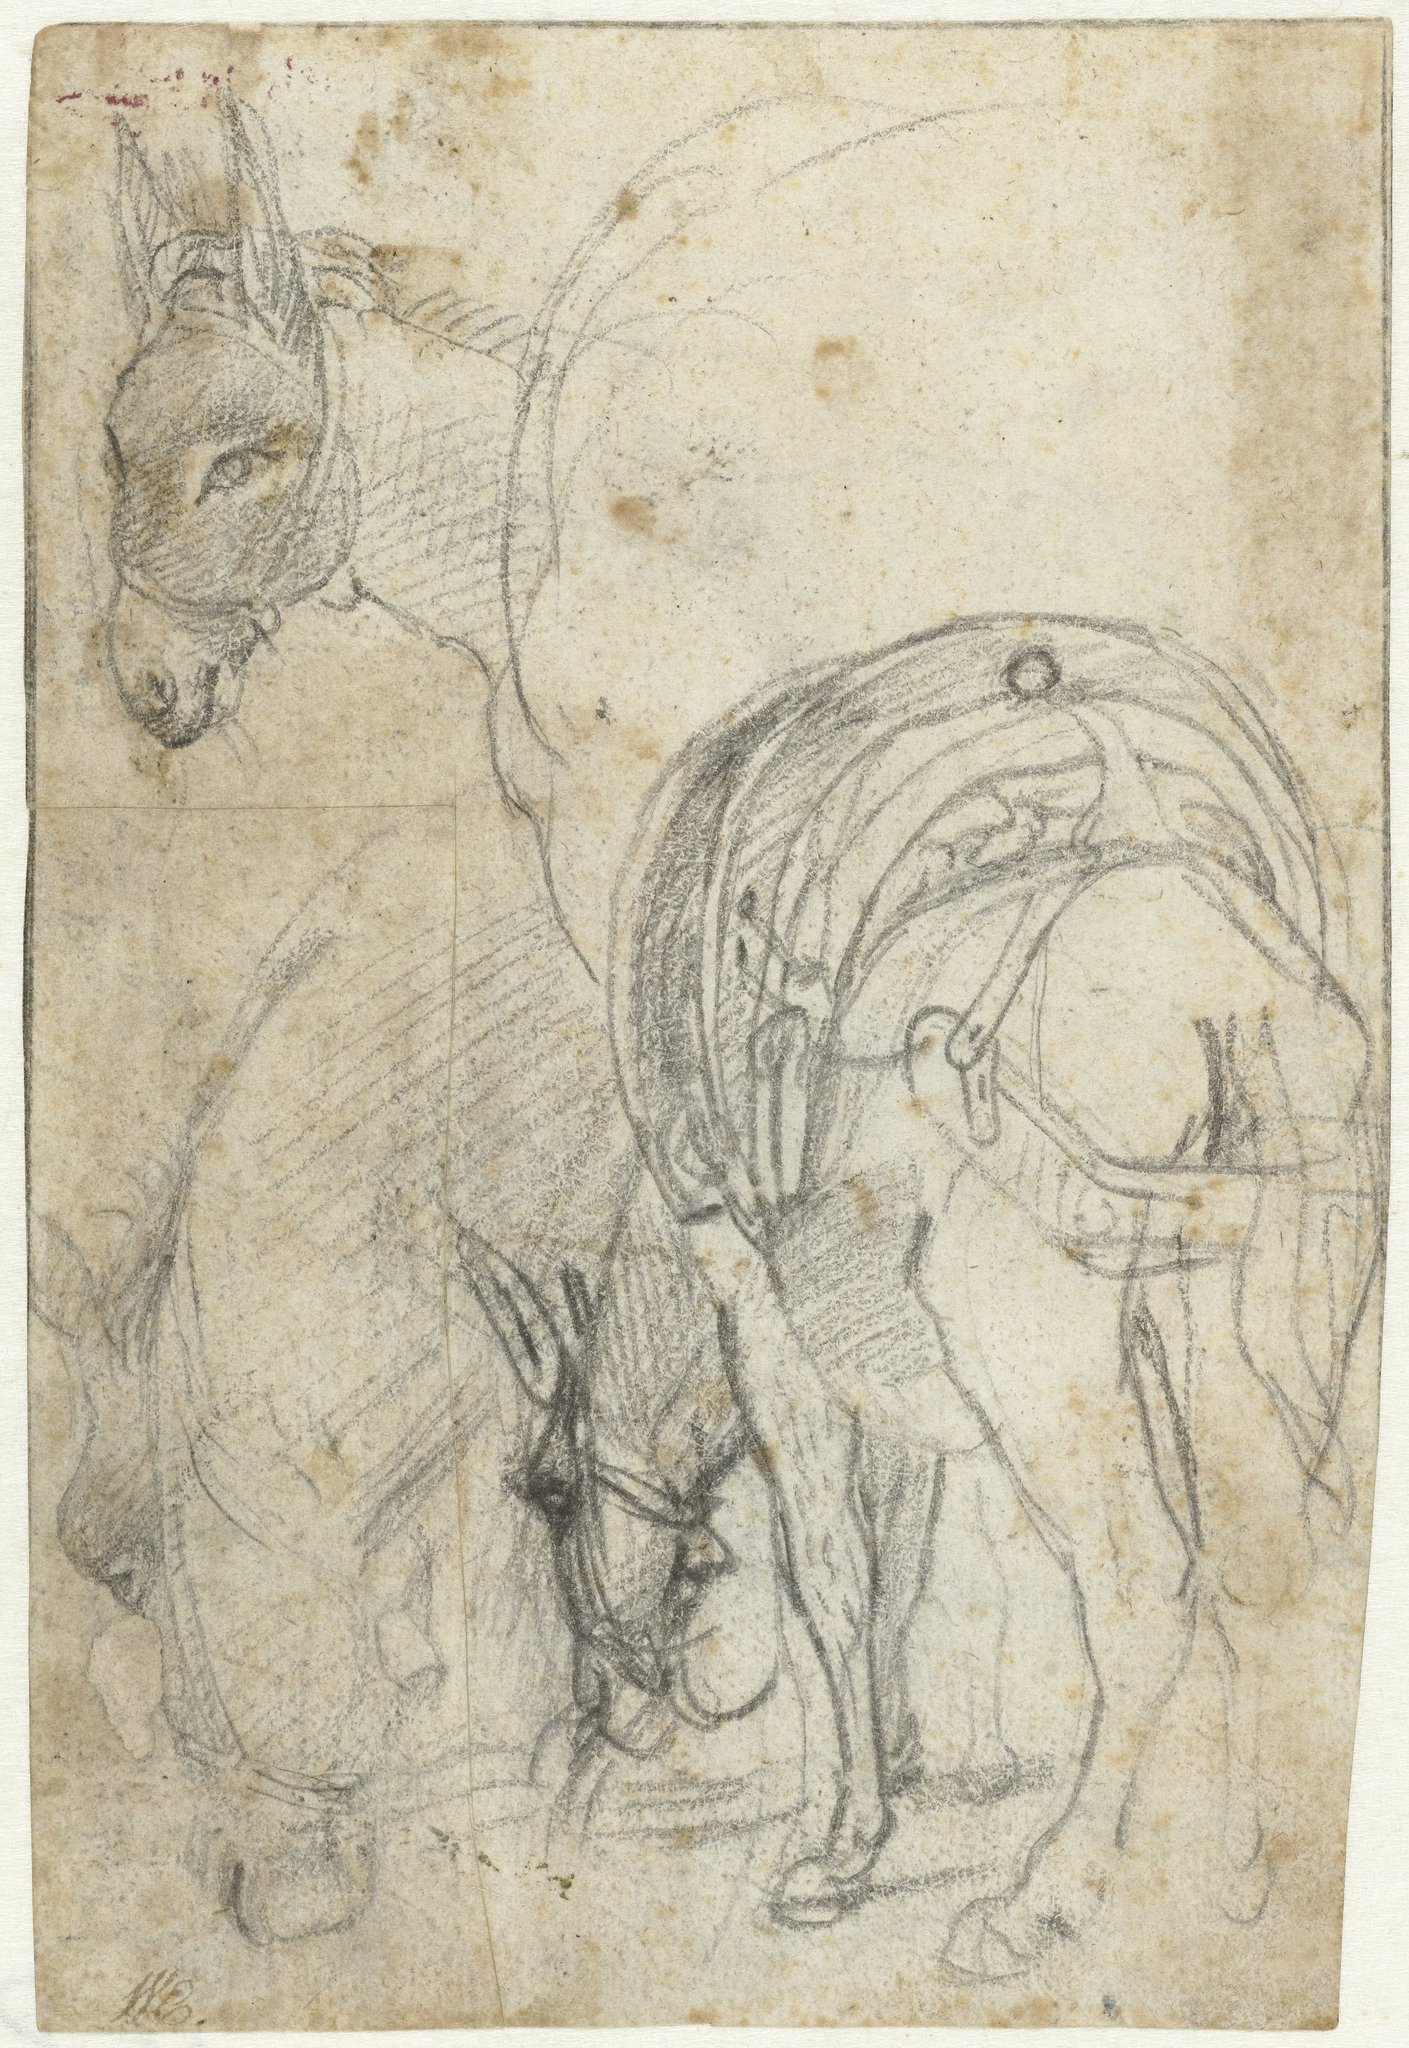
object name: drawing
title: Studies van een ezel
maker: federico barocci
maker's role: draughtsman, painter, print maker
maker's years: 1528-1612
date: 1545-1612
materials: chalk, paper